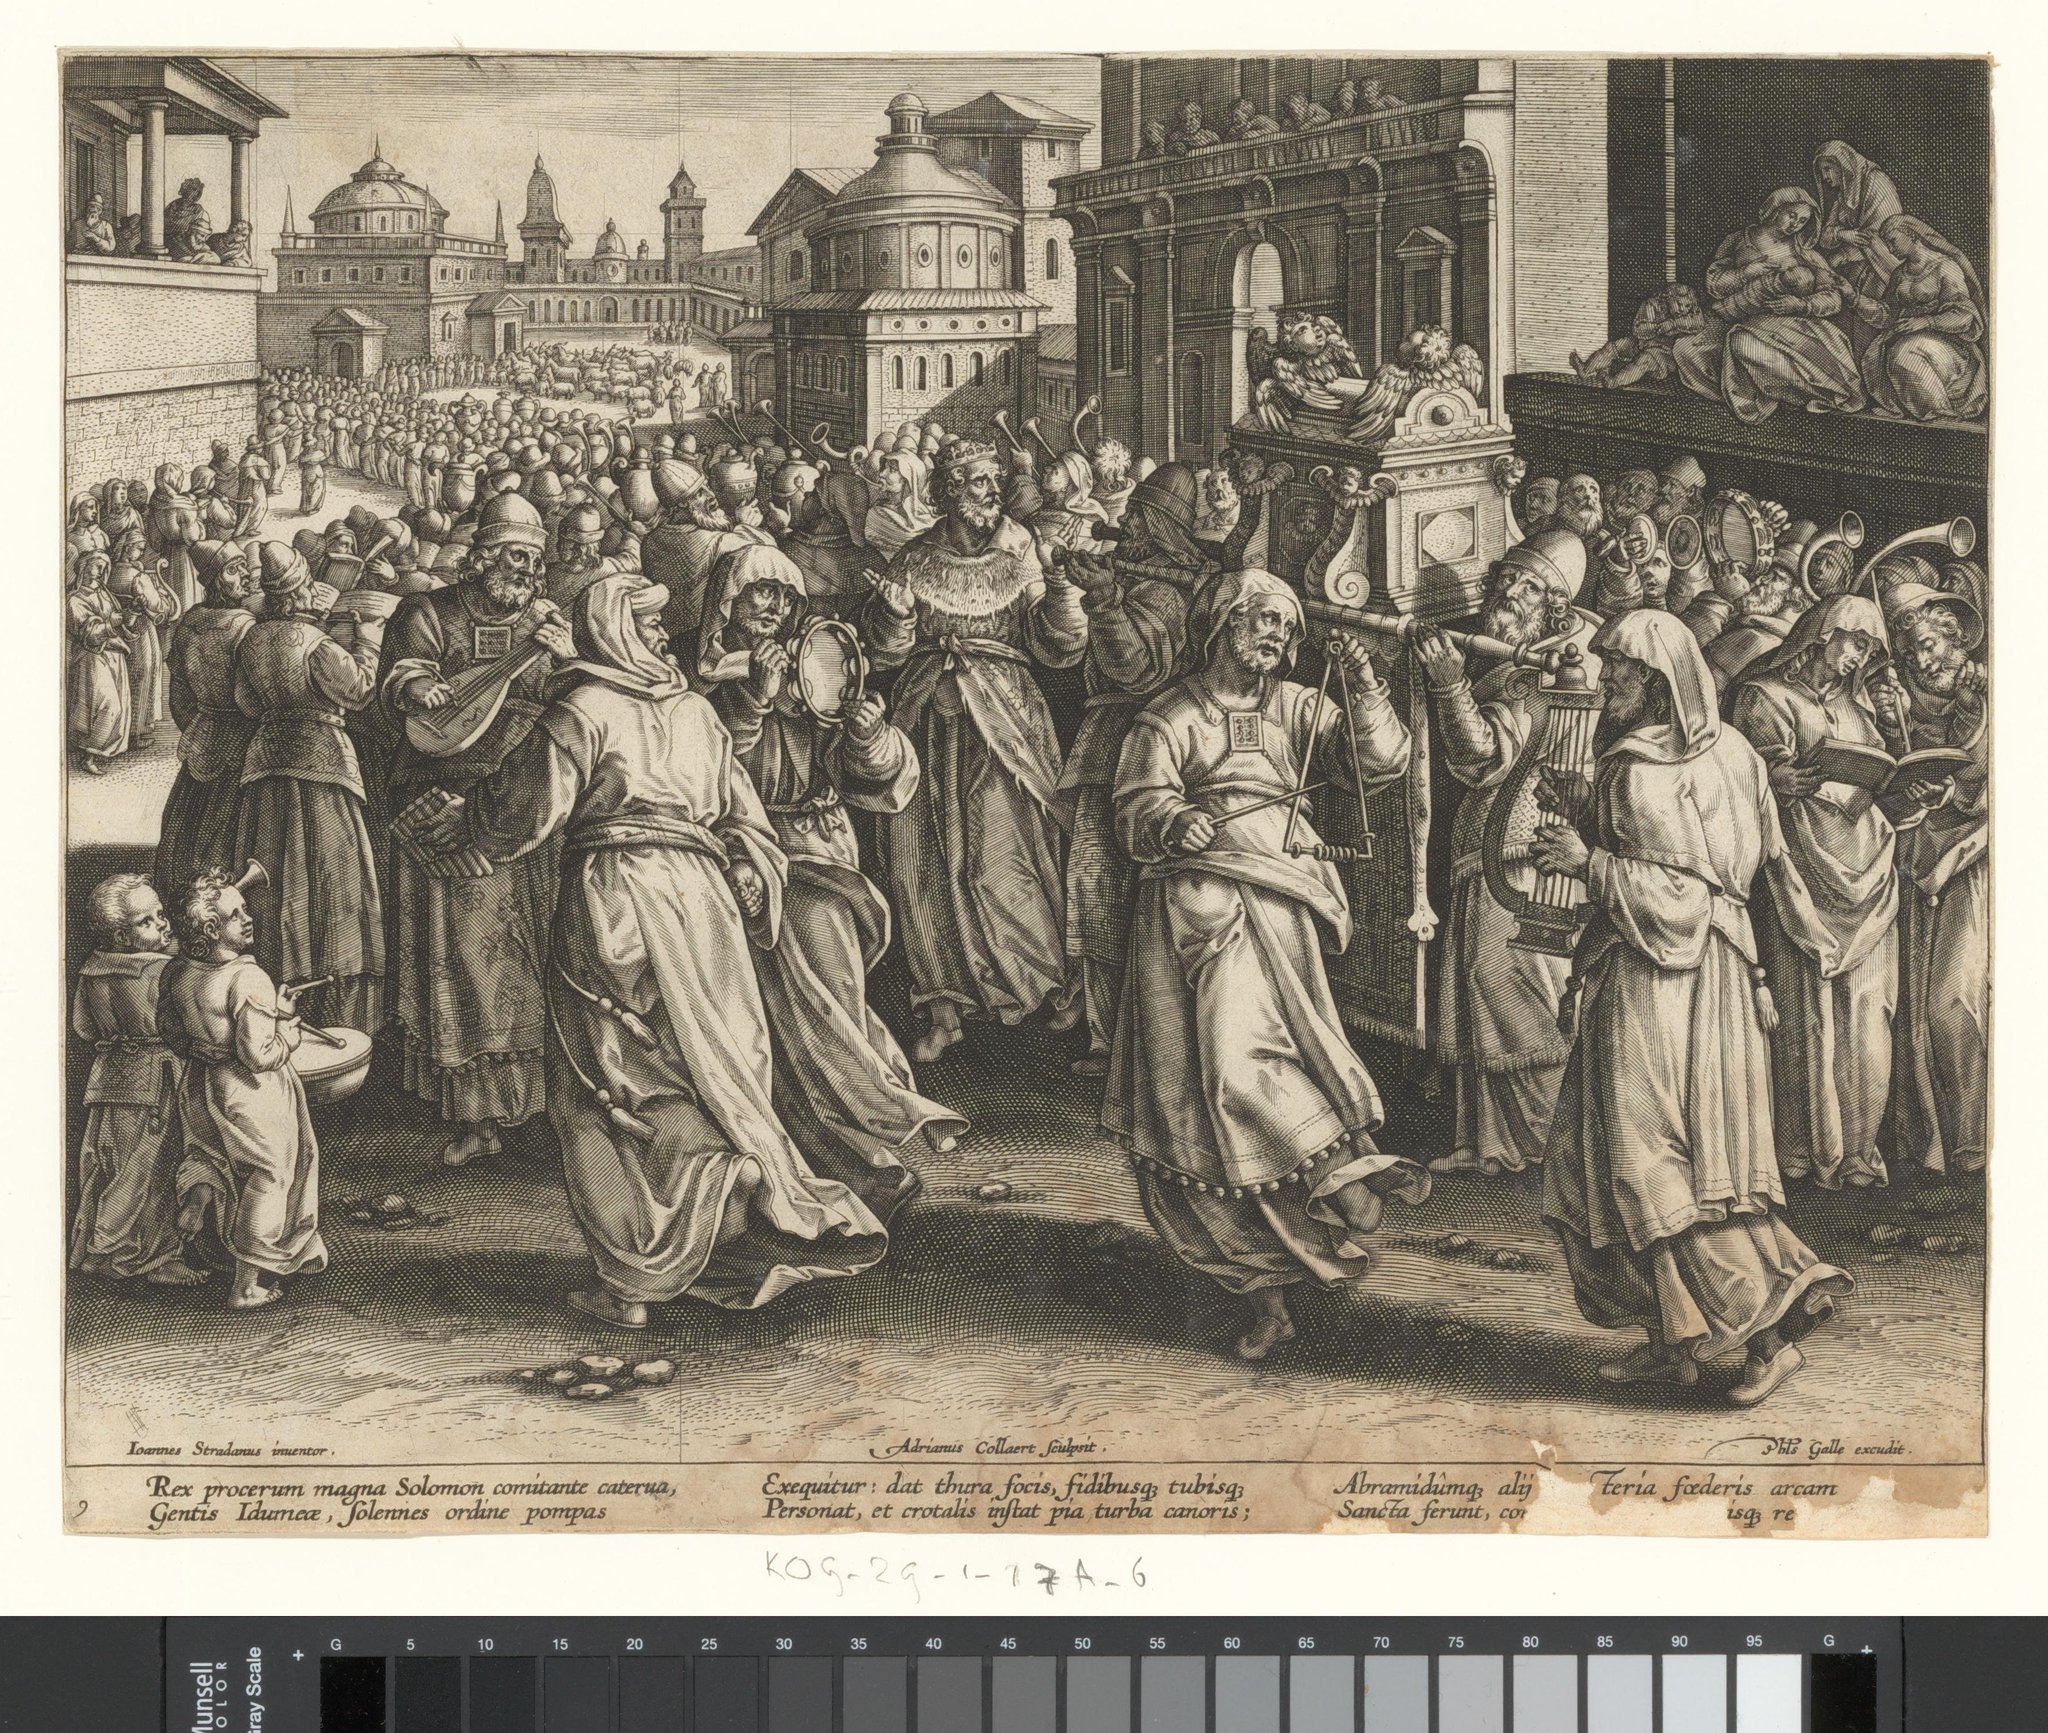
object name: print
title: Ark des verbonds overgebracht naar de tempel van Salomo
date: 1587-1592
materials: paper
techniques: engraving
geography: antwerp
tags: musical instruments; group of musical instruments, the ark of the covenant is brought into the temple; a cloud fills the house of the lord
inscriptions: collector's mark: Lugt 1641, stamp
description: De Ark des verbonds wordt in een stoet naar de tempel van Salomo gedragen. Koning Salomo loopt voor de Ark uit. Er wordt gezongen uit muziekboeken en gespeeld op bazuinen, panfluit, tokkel- (lier, luit) en slaginstrumenten (trommels, triangel, tamboerijn). De prent heeft een Latijns onderschrift met verzen. Rechtsonder een verwijzing naar 2 Kronieken 5. Linksonder genummerd: 9. Onderwerpsrubrieken binnen de Atlas Zeden en Gewoonten: Muziek en muziekinstrumenten: Muziekinstrumenten op bijbelprenten.